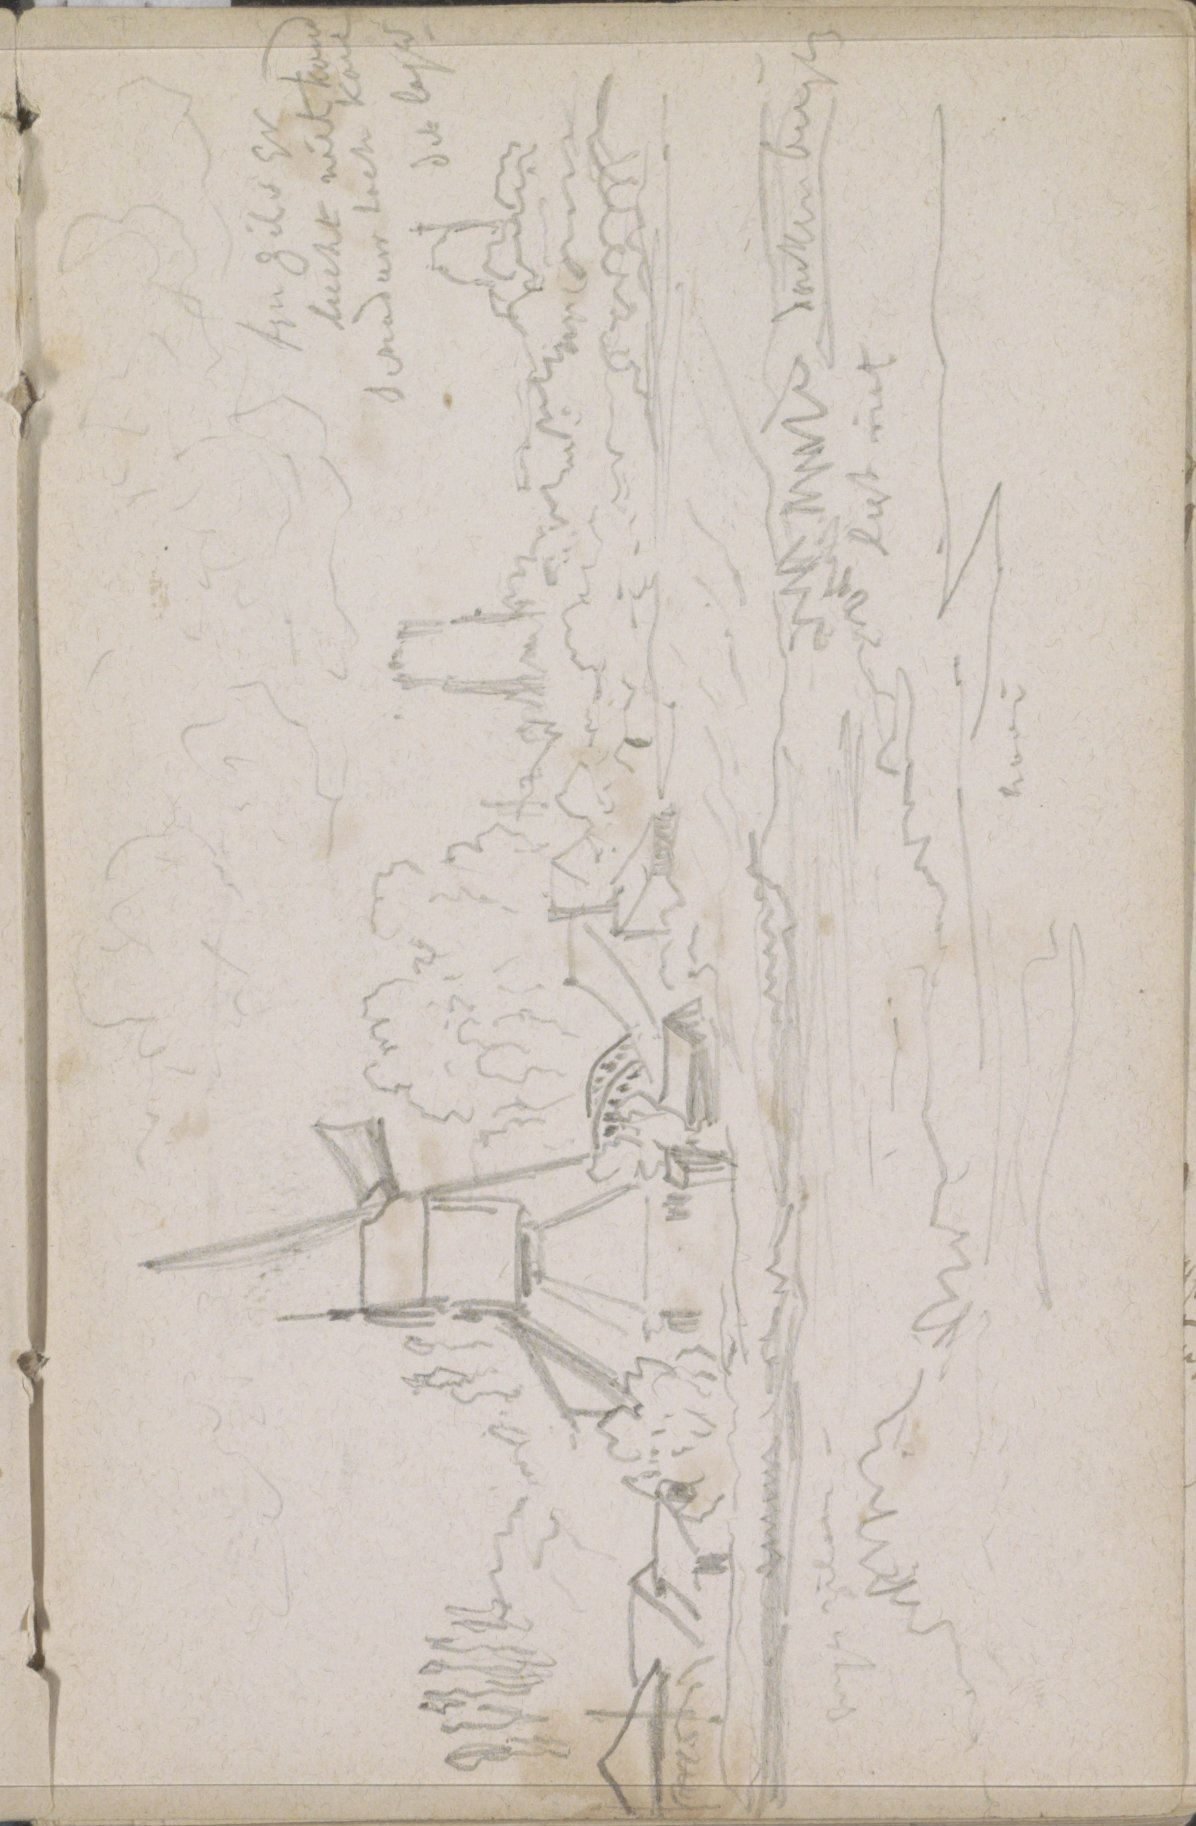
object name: sketchbook leaf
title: Landschap met een molen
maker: johannes tavenraat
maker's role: draughtsman, painter, print maker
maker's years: 1809-1881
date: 1862-1864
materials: paper, pencil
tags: windmill in landscape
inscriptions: kleurnotitie, handgeschreven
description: Blad 5 recto uit een schetsboek met 65 bladen.